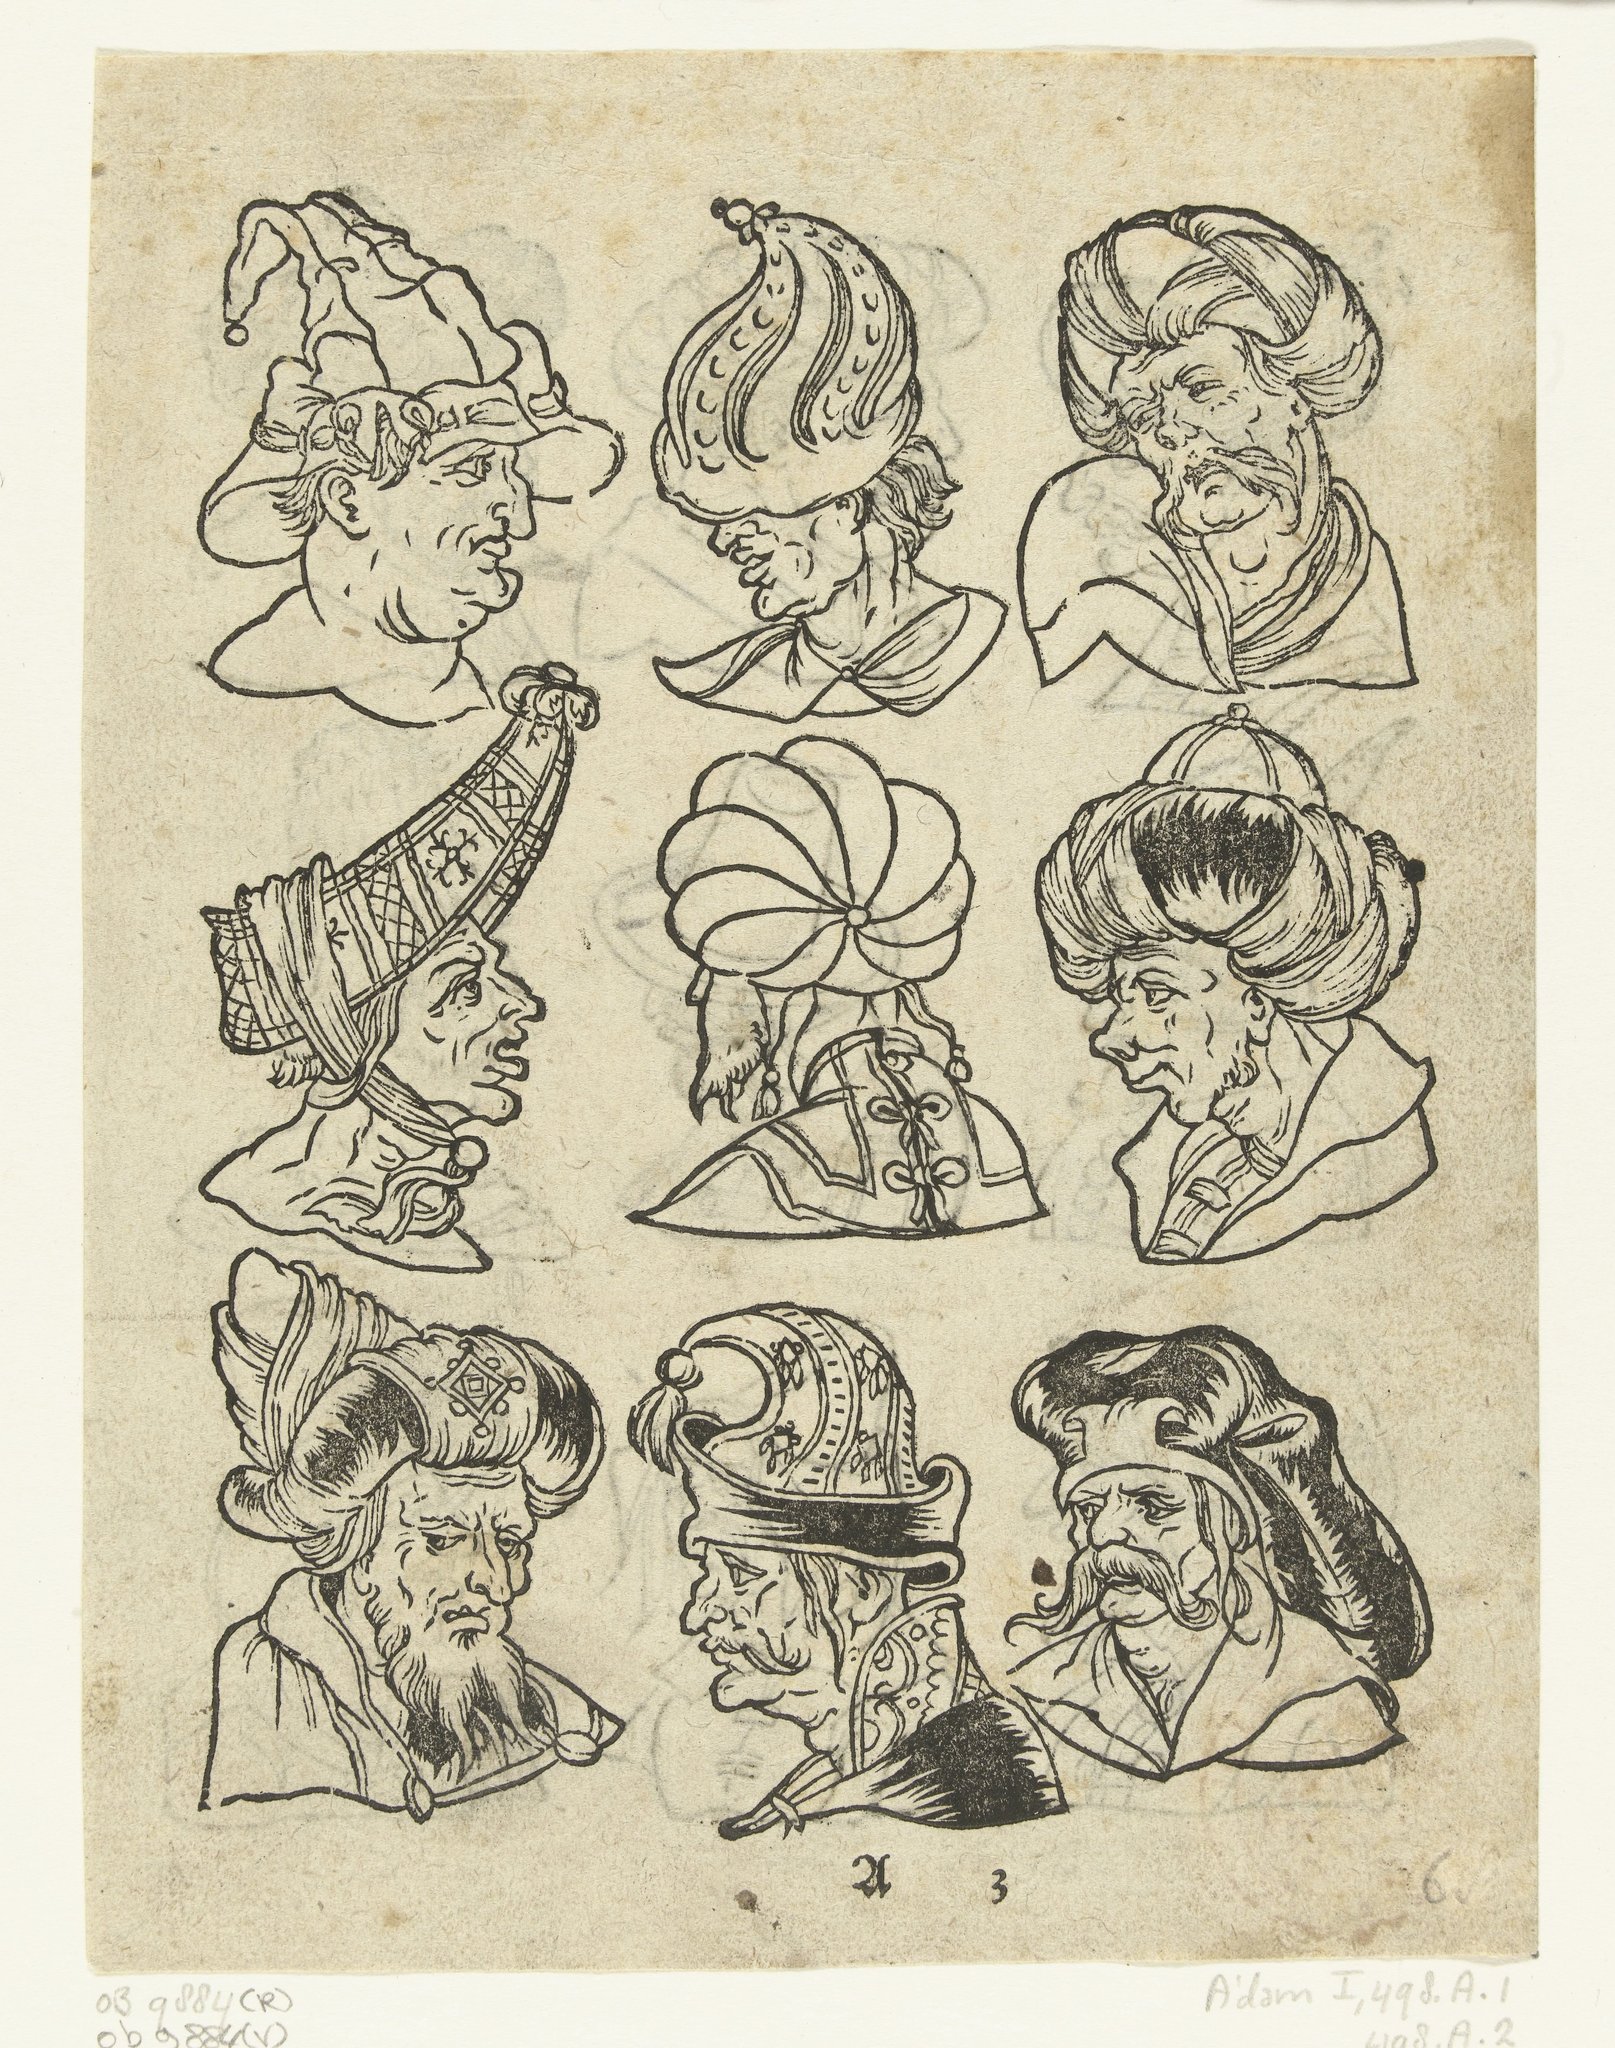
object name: ornament print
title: Negen mannenhoofden met exotische hoofdbedekkingen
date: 1500-1568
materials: paper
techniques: woodcut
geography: germany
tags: head-gear, head-gear: turban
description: In het midden wordt een man met strikken op zijn rug van achteren gezien. Blad uit serie van 56 (?) bladen.